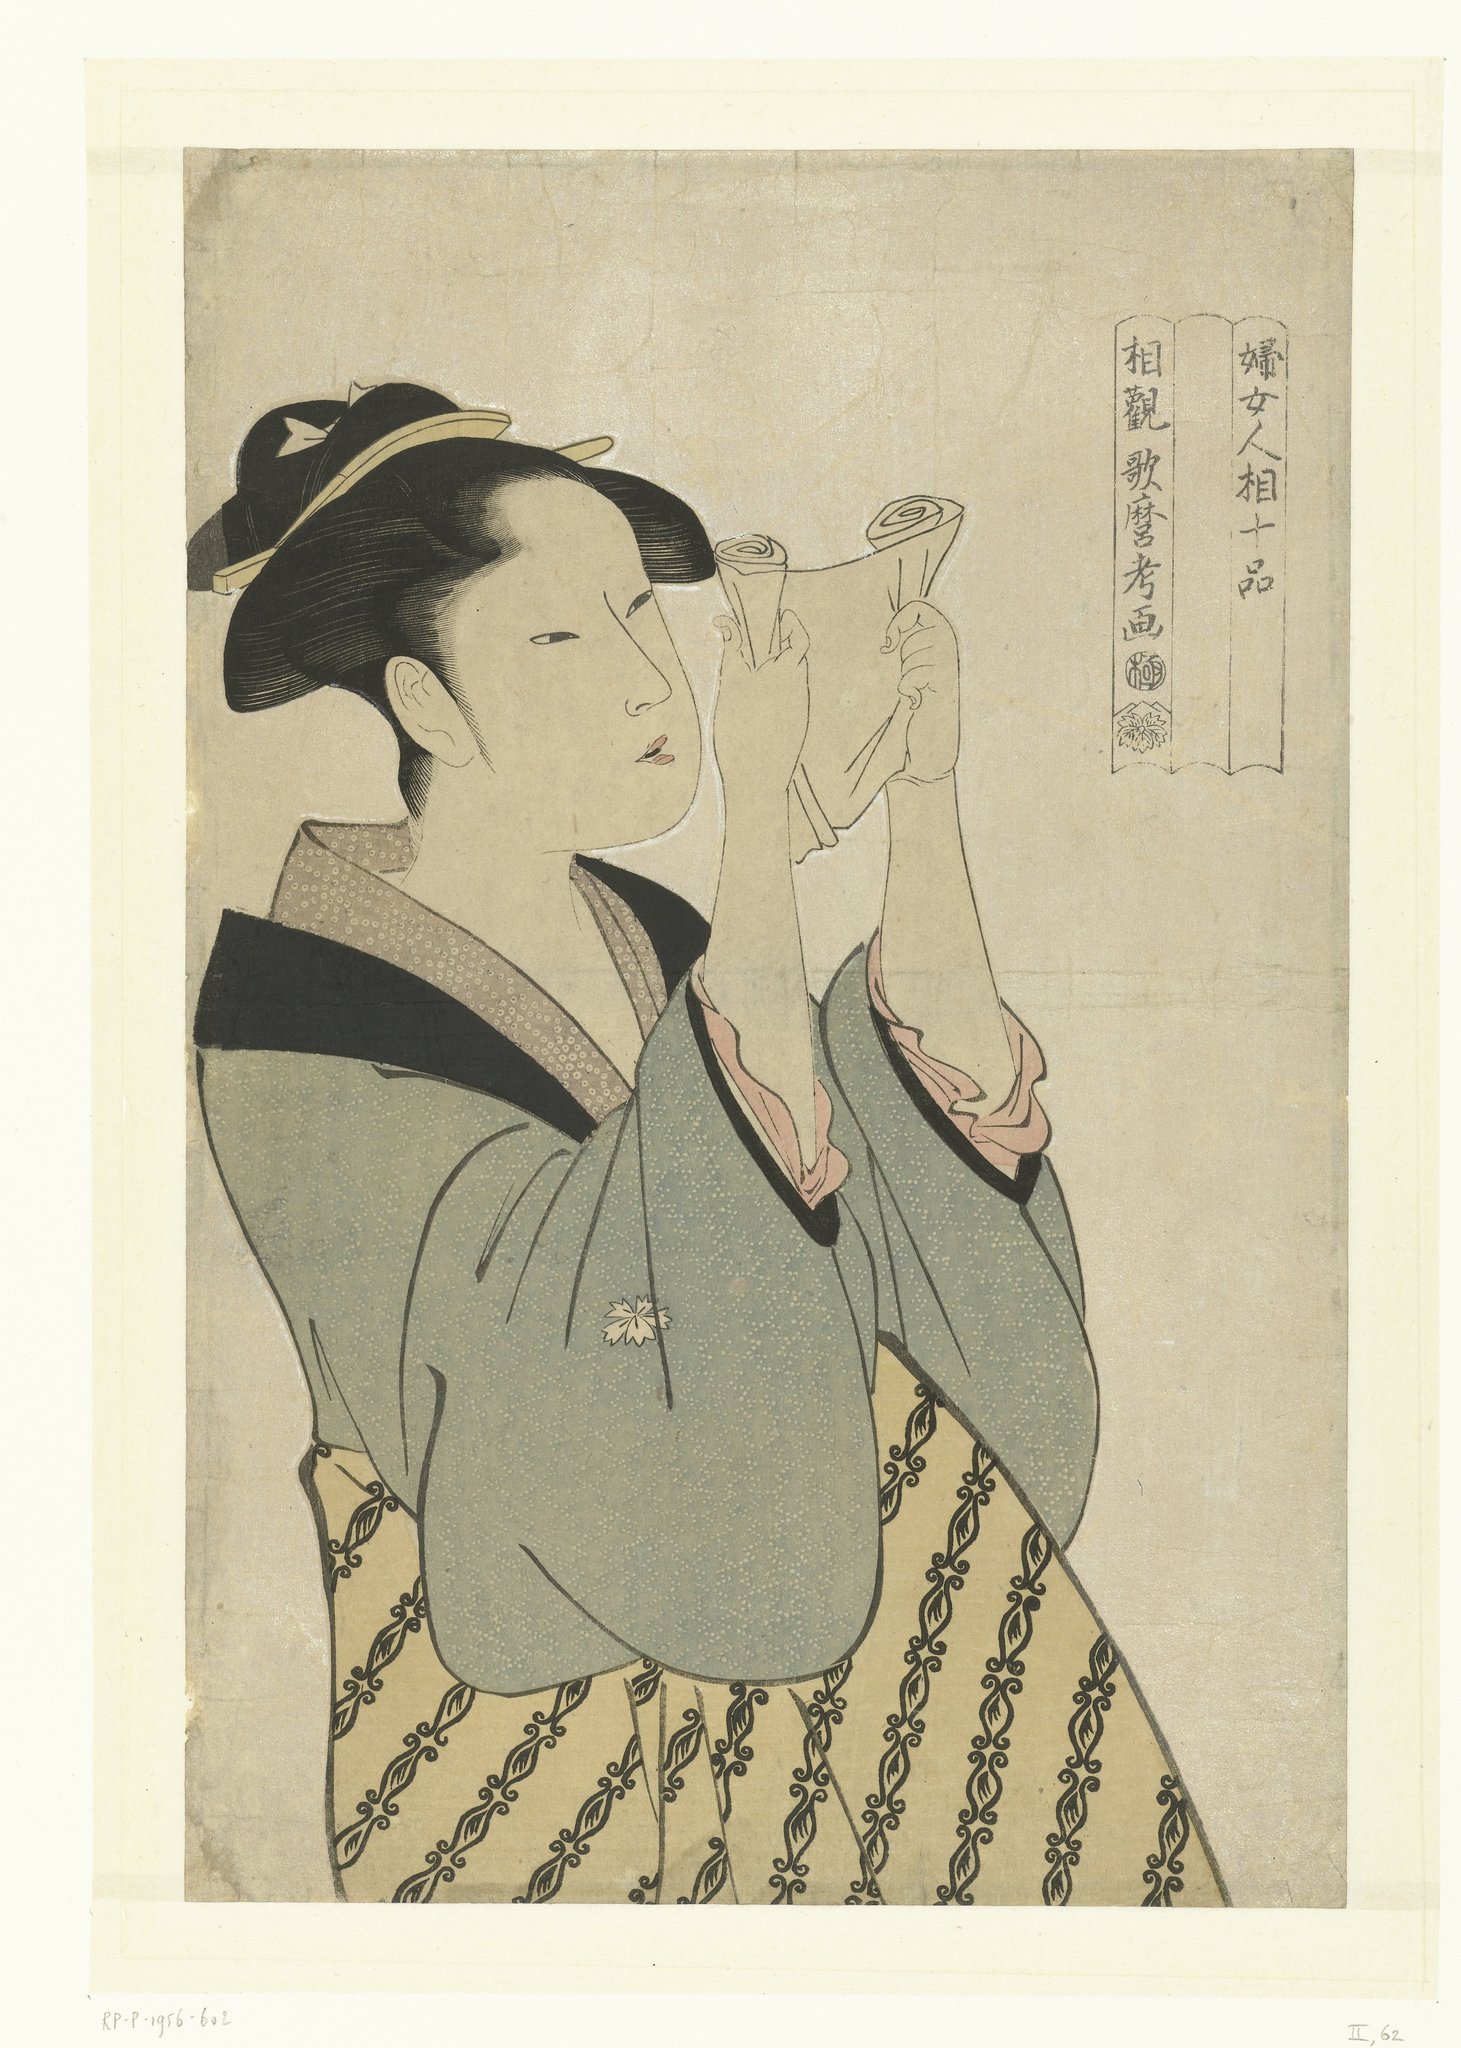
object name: print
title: Tien aspecten van vrouwelijke gelaatstrekken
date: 1793-1797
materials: paper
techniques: woodcut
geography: japan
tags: adult woman, letter, envelope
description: Vrouw, ten halven lijve, een brief lezend; tegen mica achtergrond.